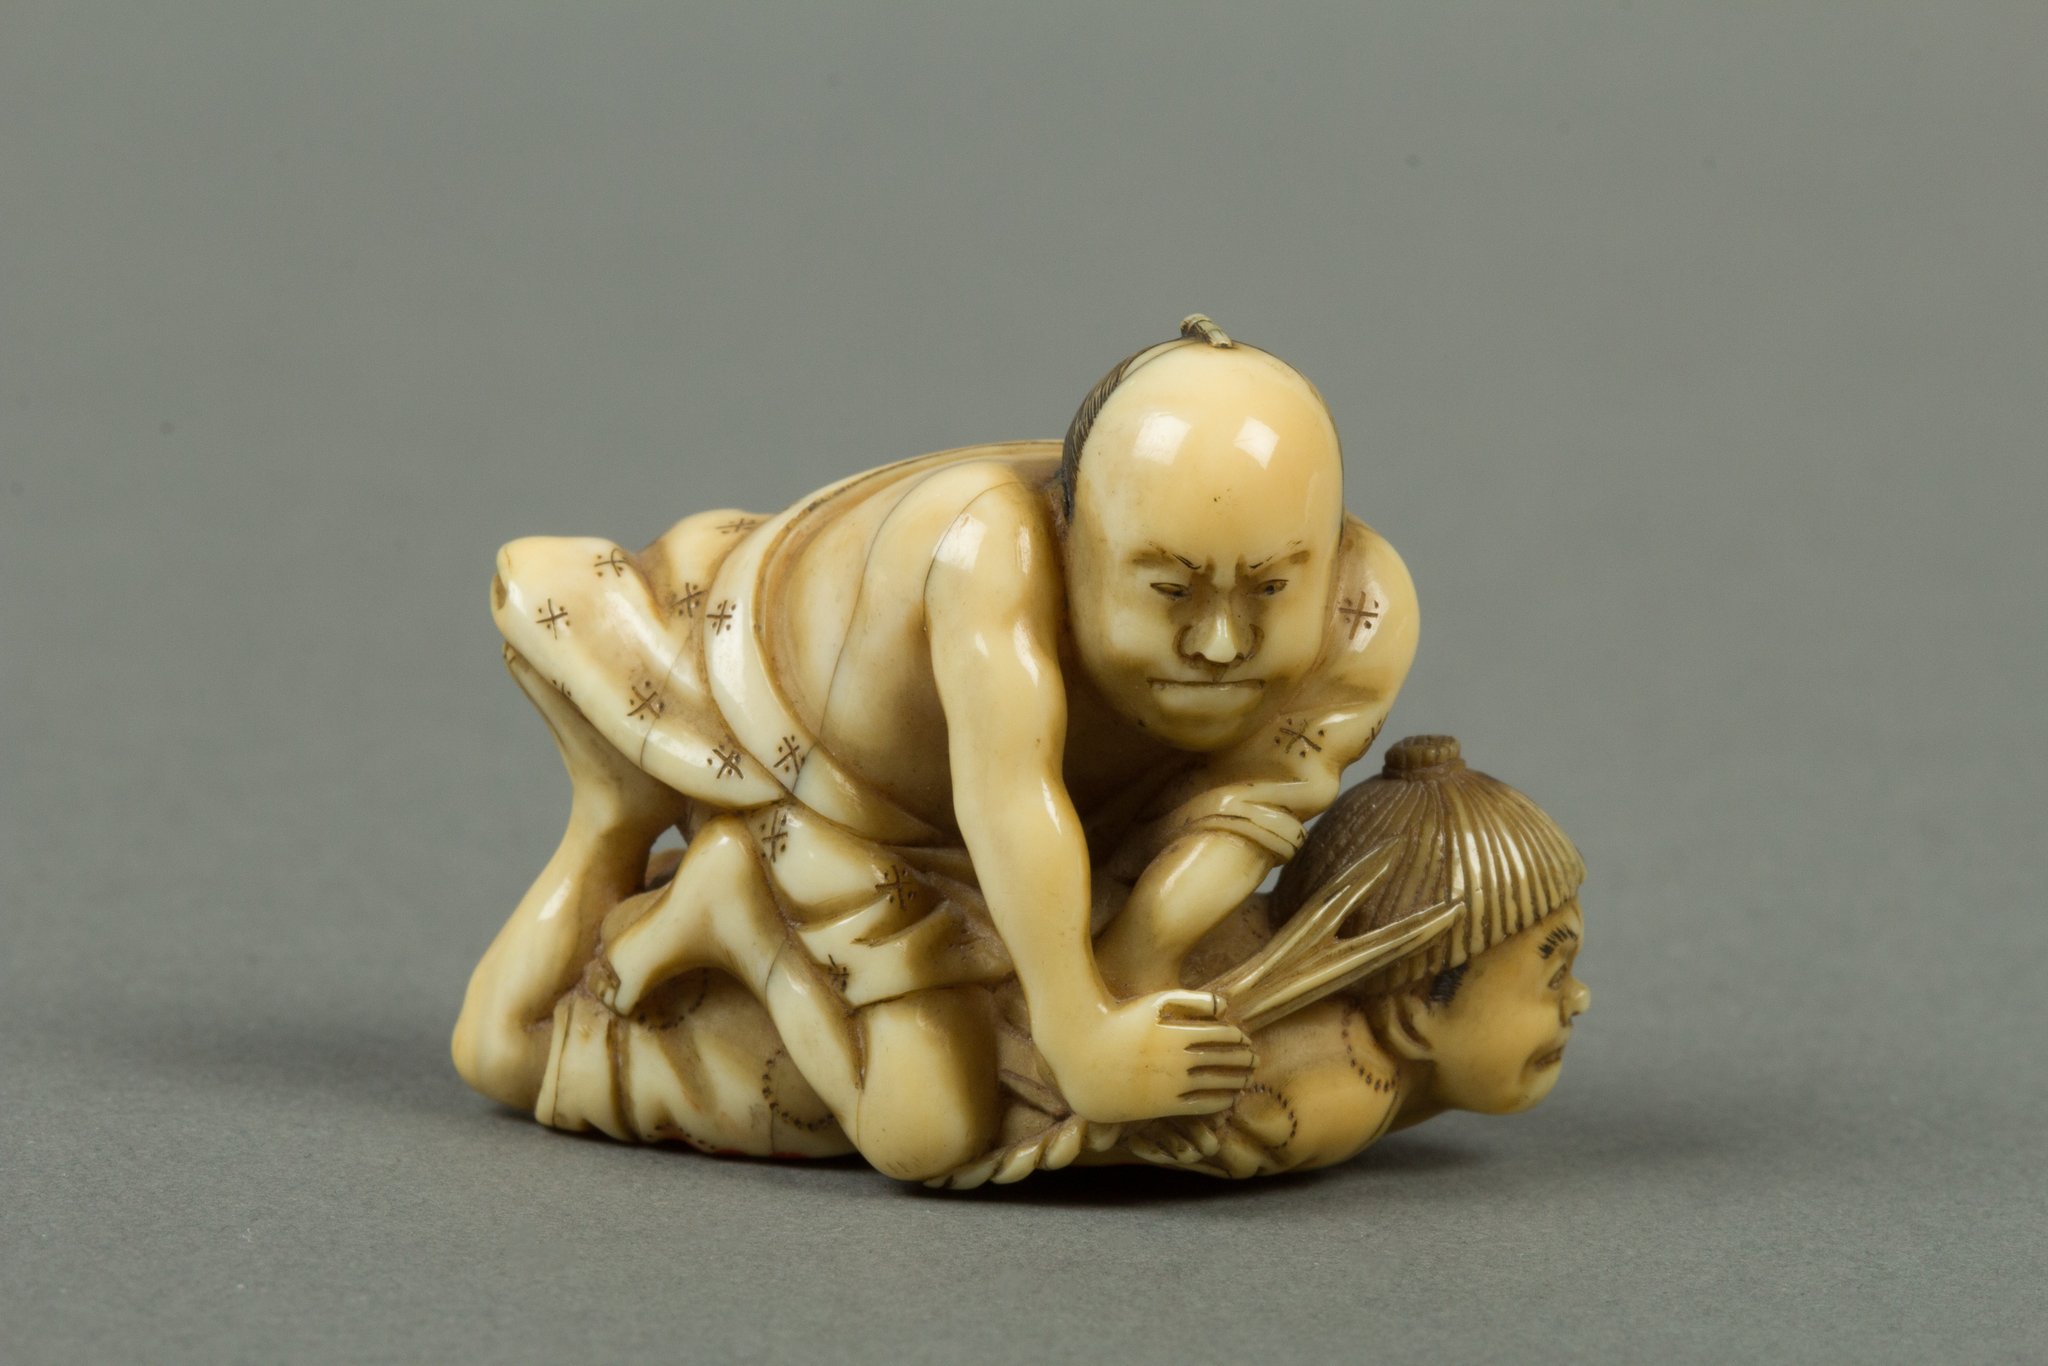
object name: netsuke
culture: japanese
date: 1801-1900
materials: ivory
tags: men